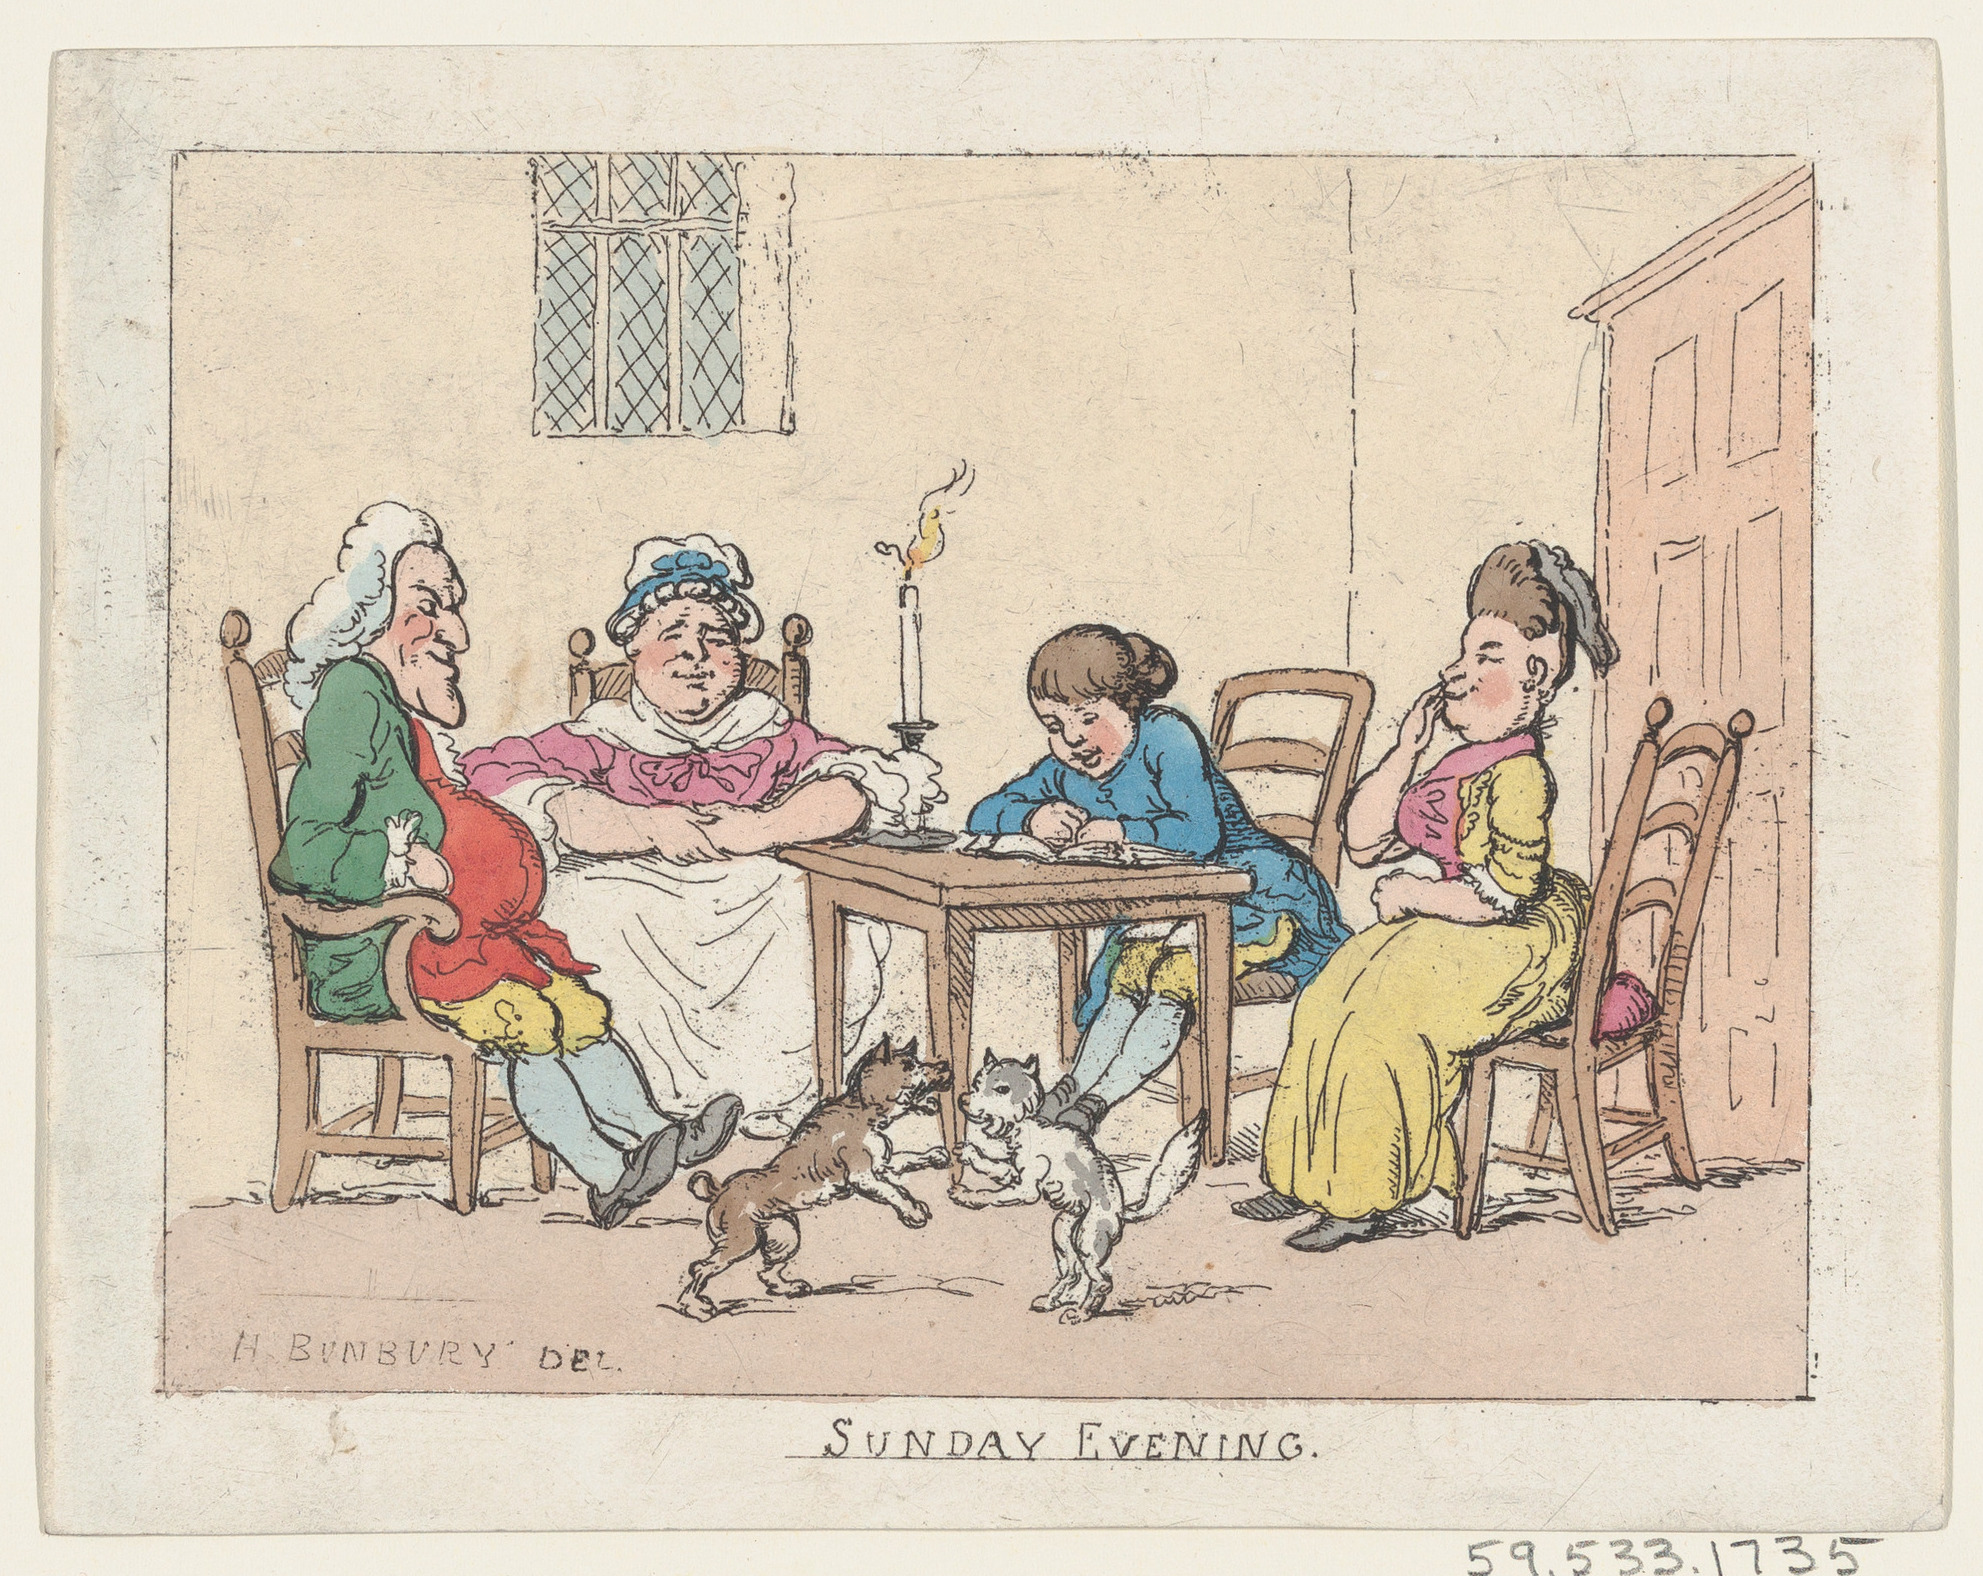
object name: print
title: Sunday Evening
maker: thomas rowlandson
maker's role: artist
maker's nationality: british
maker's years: 1757-1827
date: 1770-1780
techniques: etching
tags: satire,men,women,reading,dogs